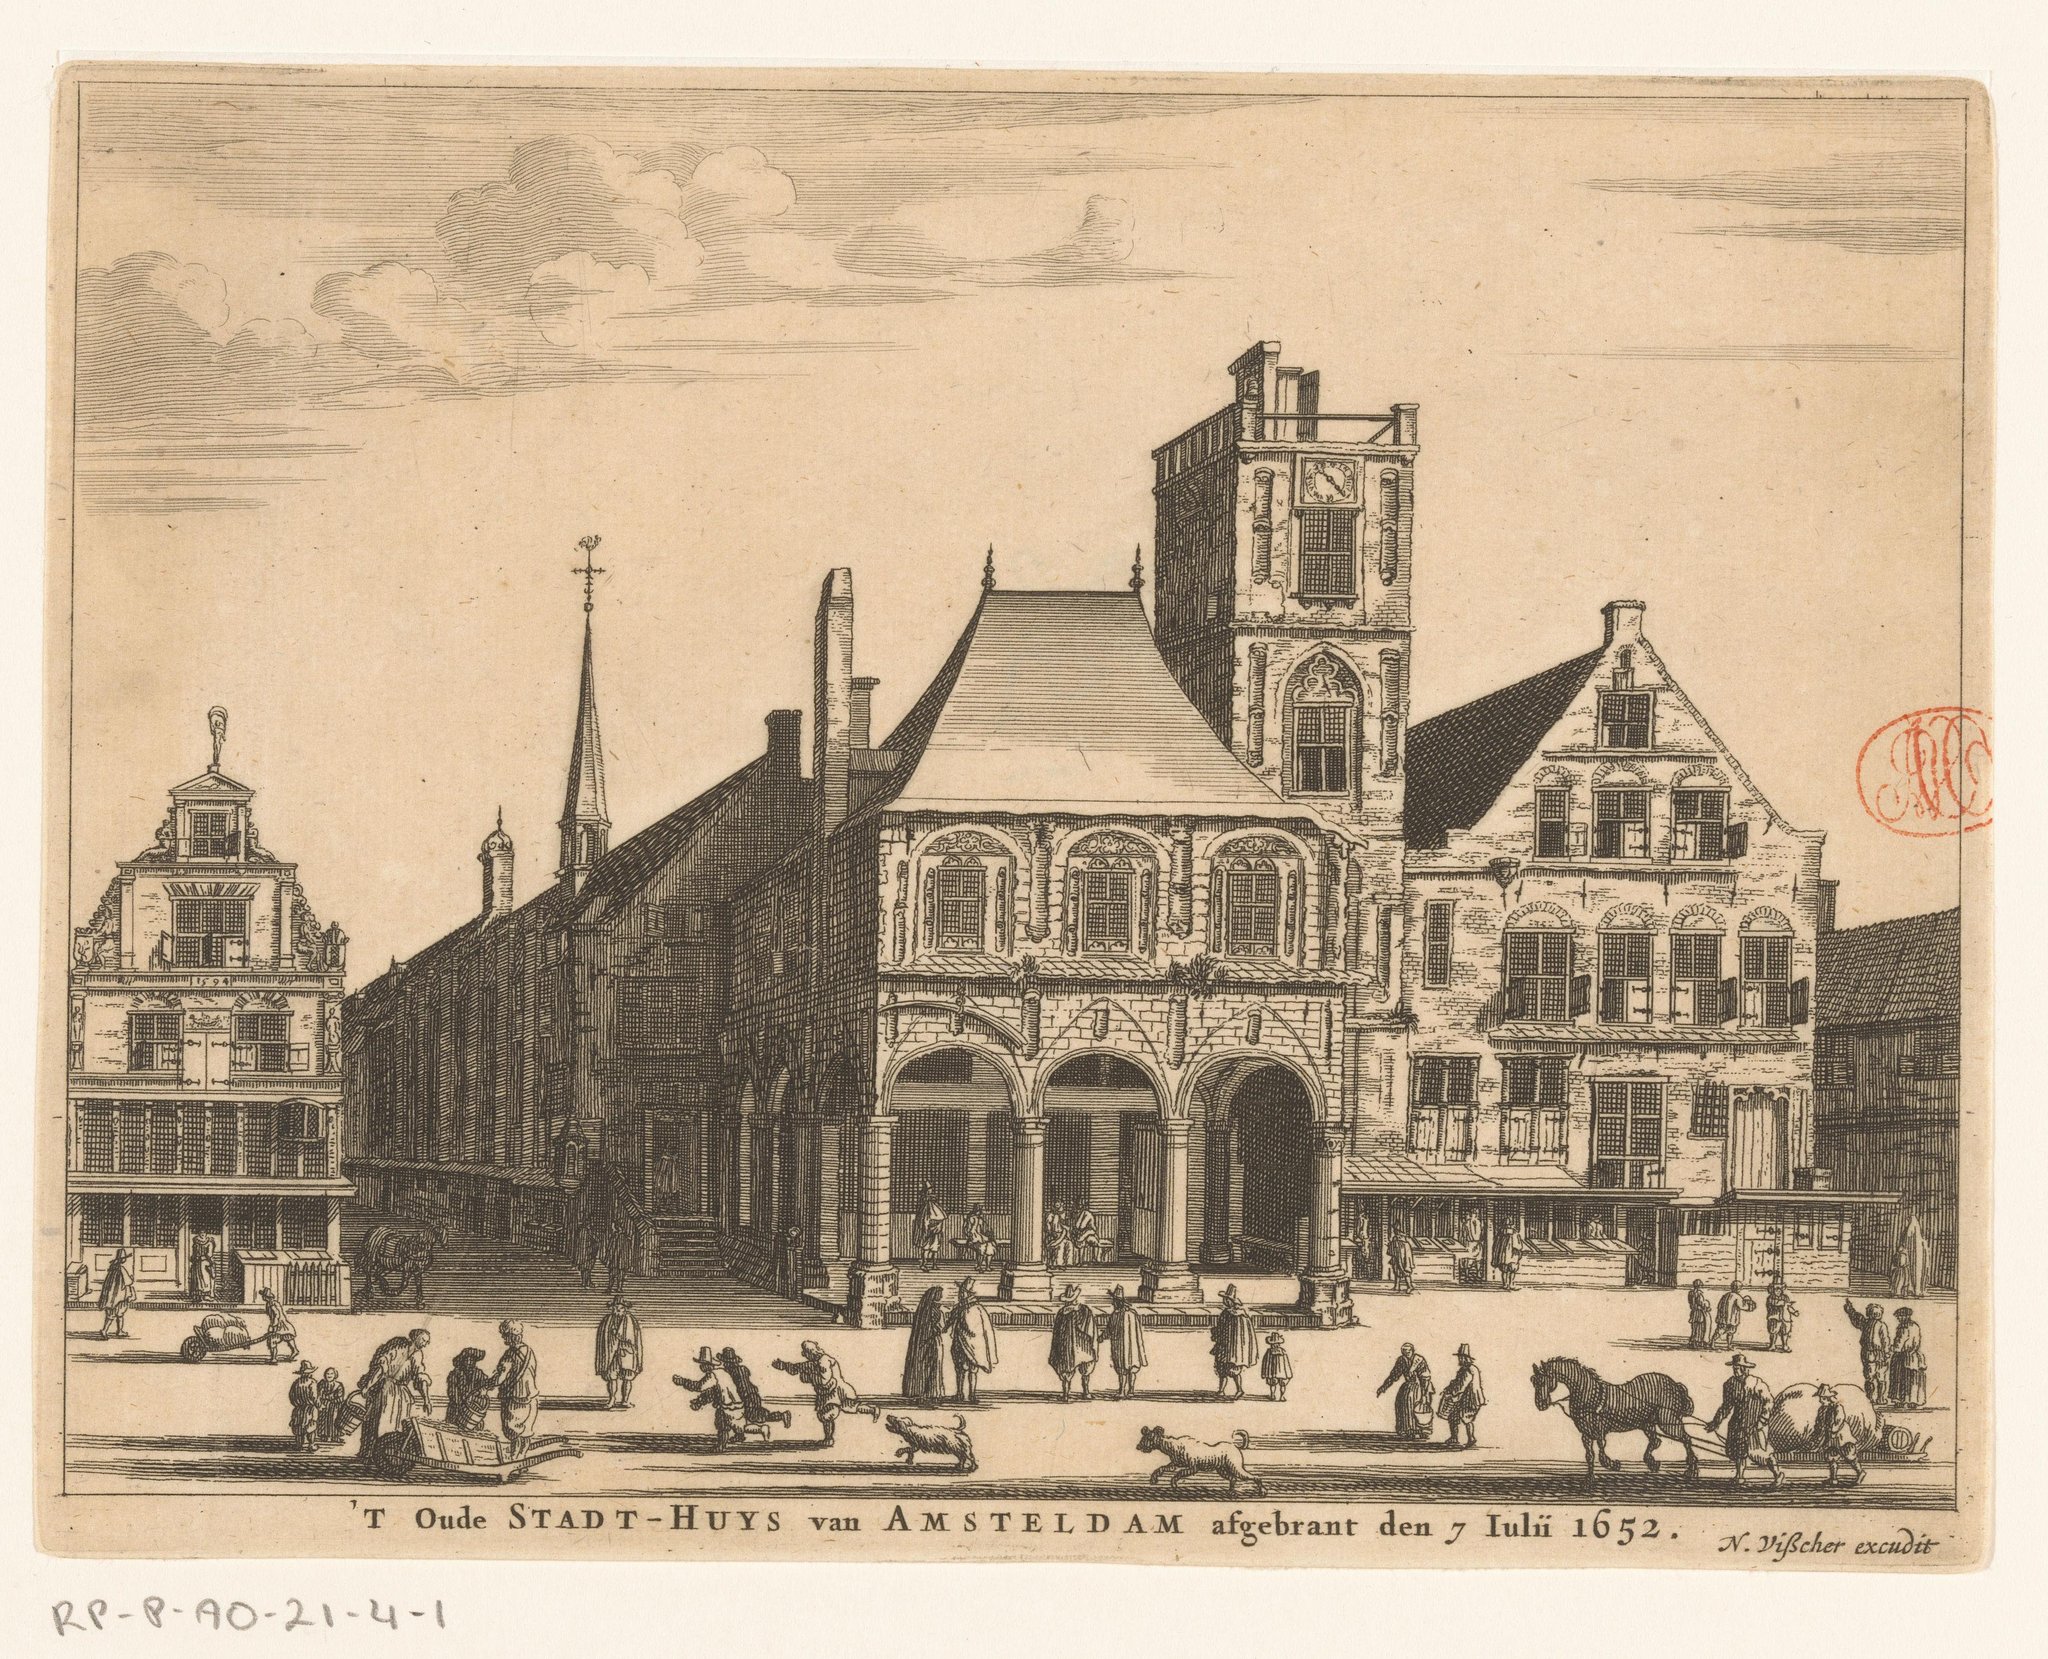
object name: print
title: 'T Oude Stadt-Huys van Amsteldam afgebrant den 7 Iulii 1652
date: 1652-1720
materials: paper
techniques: engraving, etching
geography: amsterdam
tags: townhall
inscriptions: collector's mark: Lugt 195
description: Gezicht op het Oude Stadhuis te Amsterdam op de westzijde van de Dam. Helemaal links het eerste huis van de Kalverstraat, rechts daarvan de Gasthuissteeg.